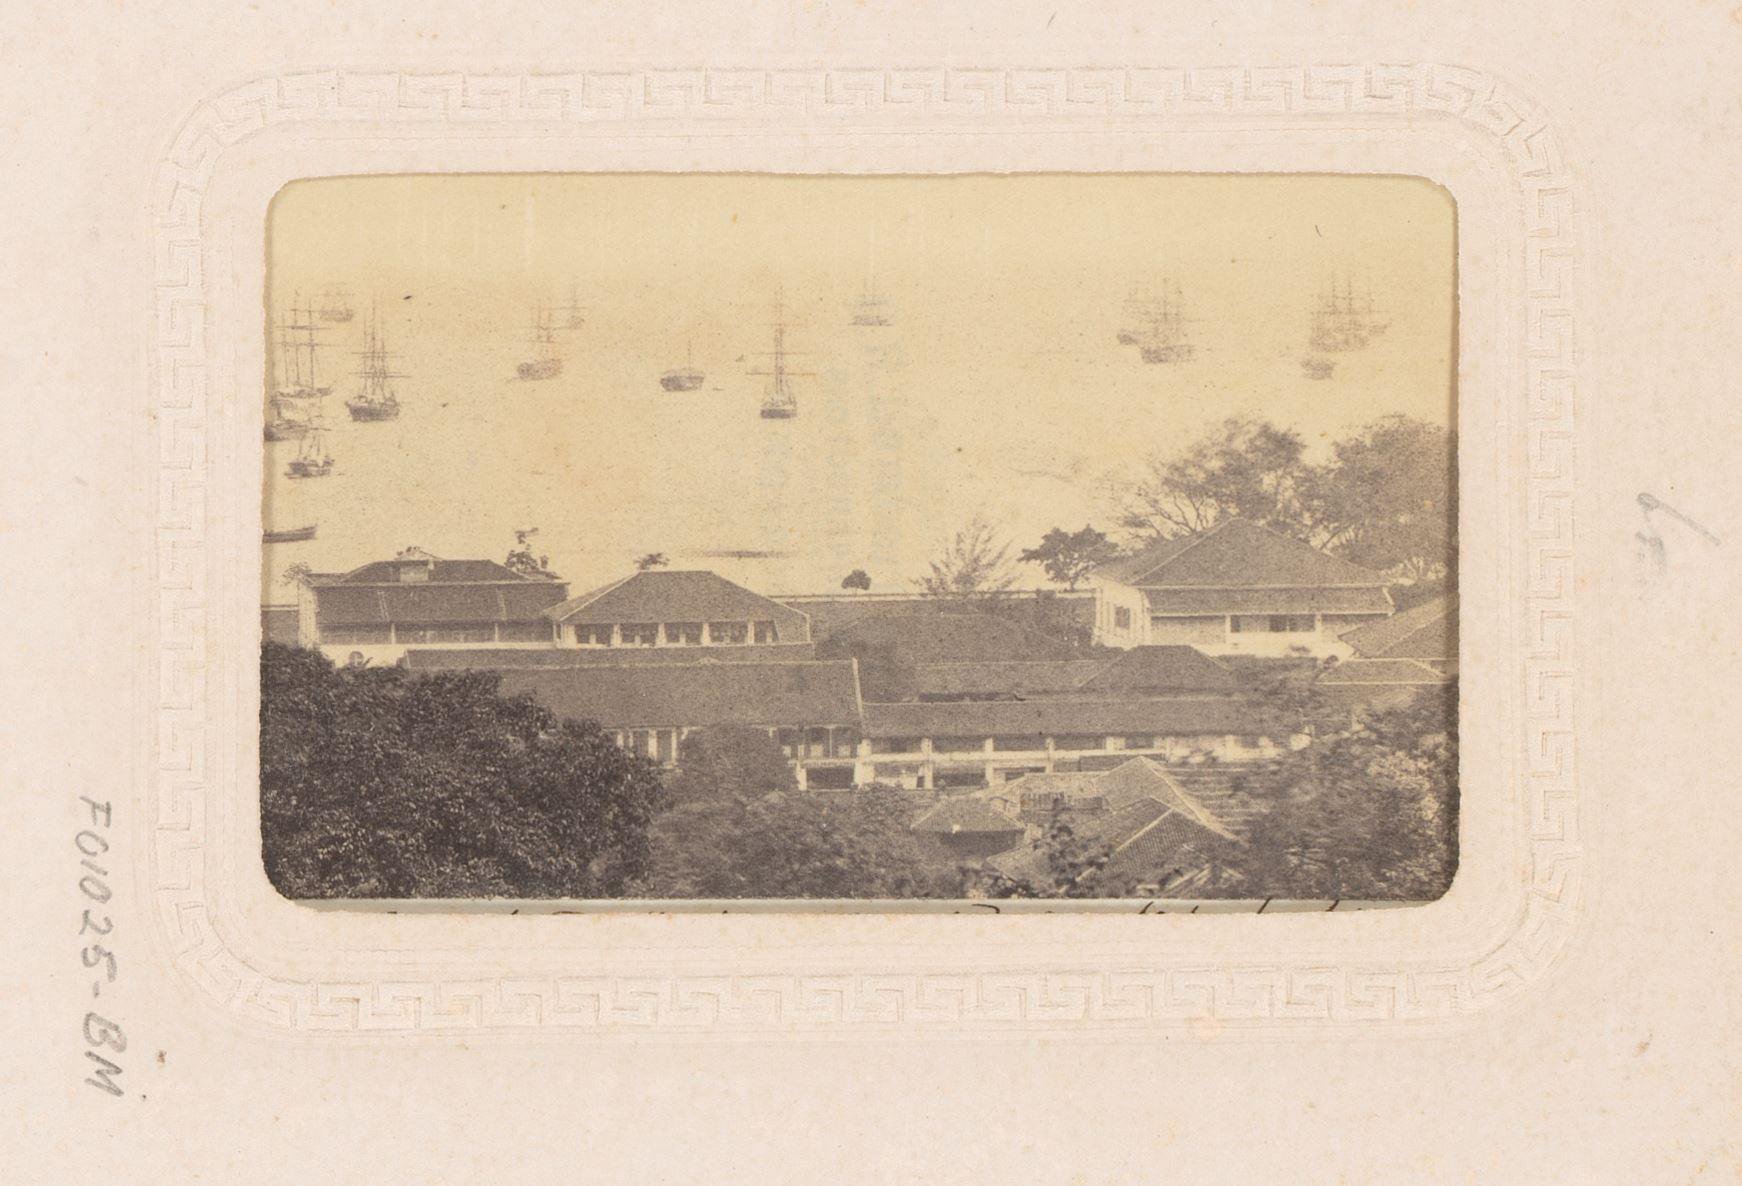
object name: photograph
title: Gezicht op de reede van Singapore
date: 1867-1880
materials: cardboard, photographic support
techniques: albumen print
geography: singapore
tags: harbour, singapore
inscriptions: number: ‘65’